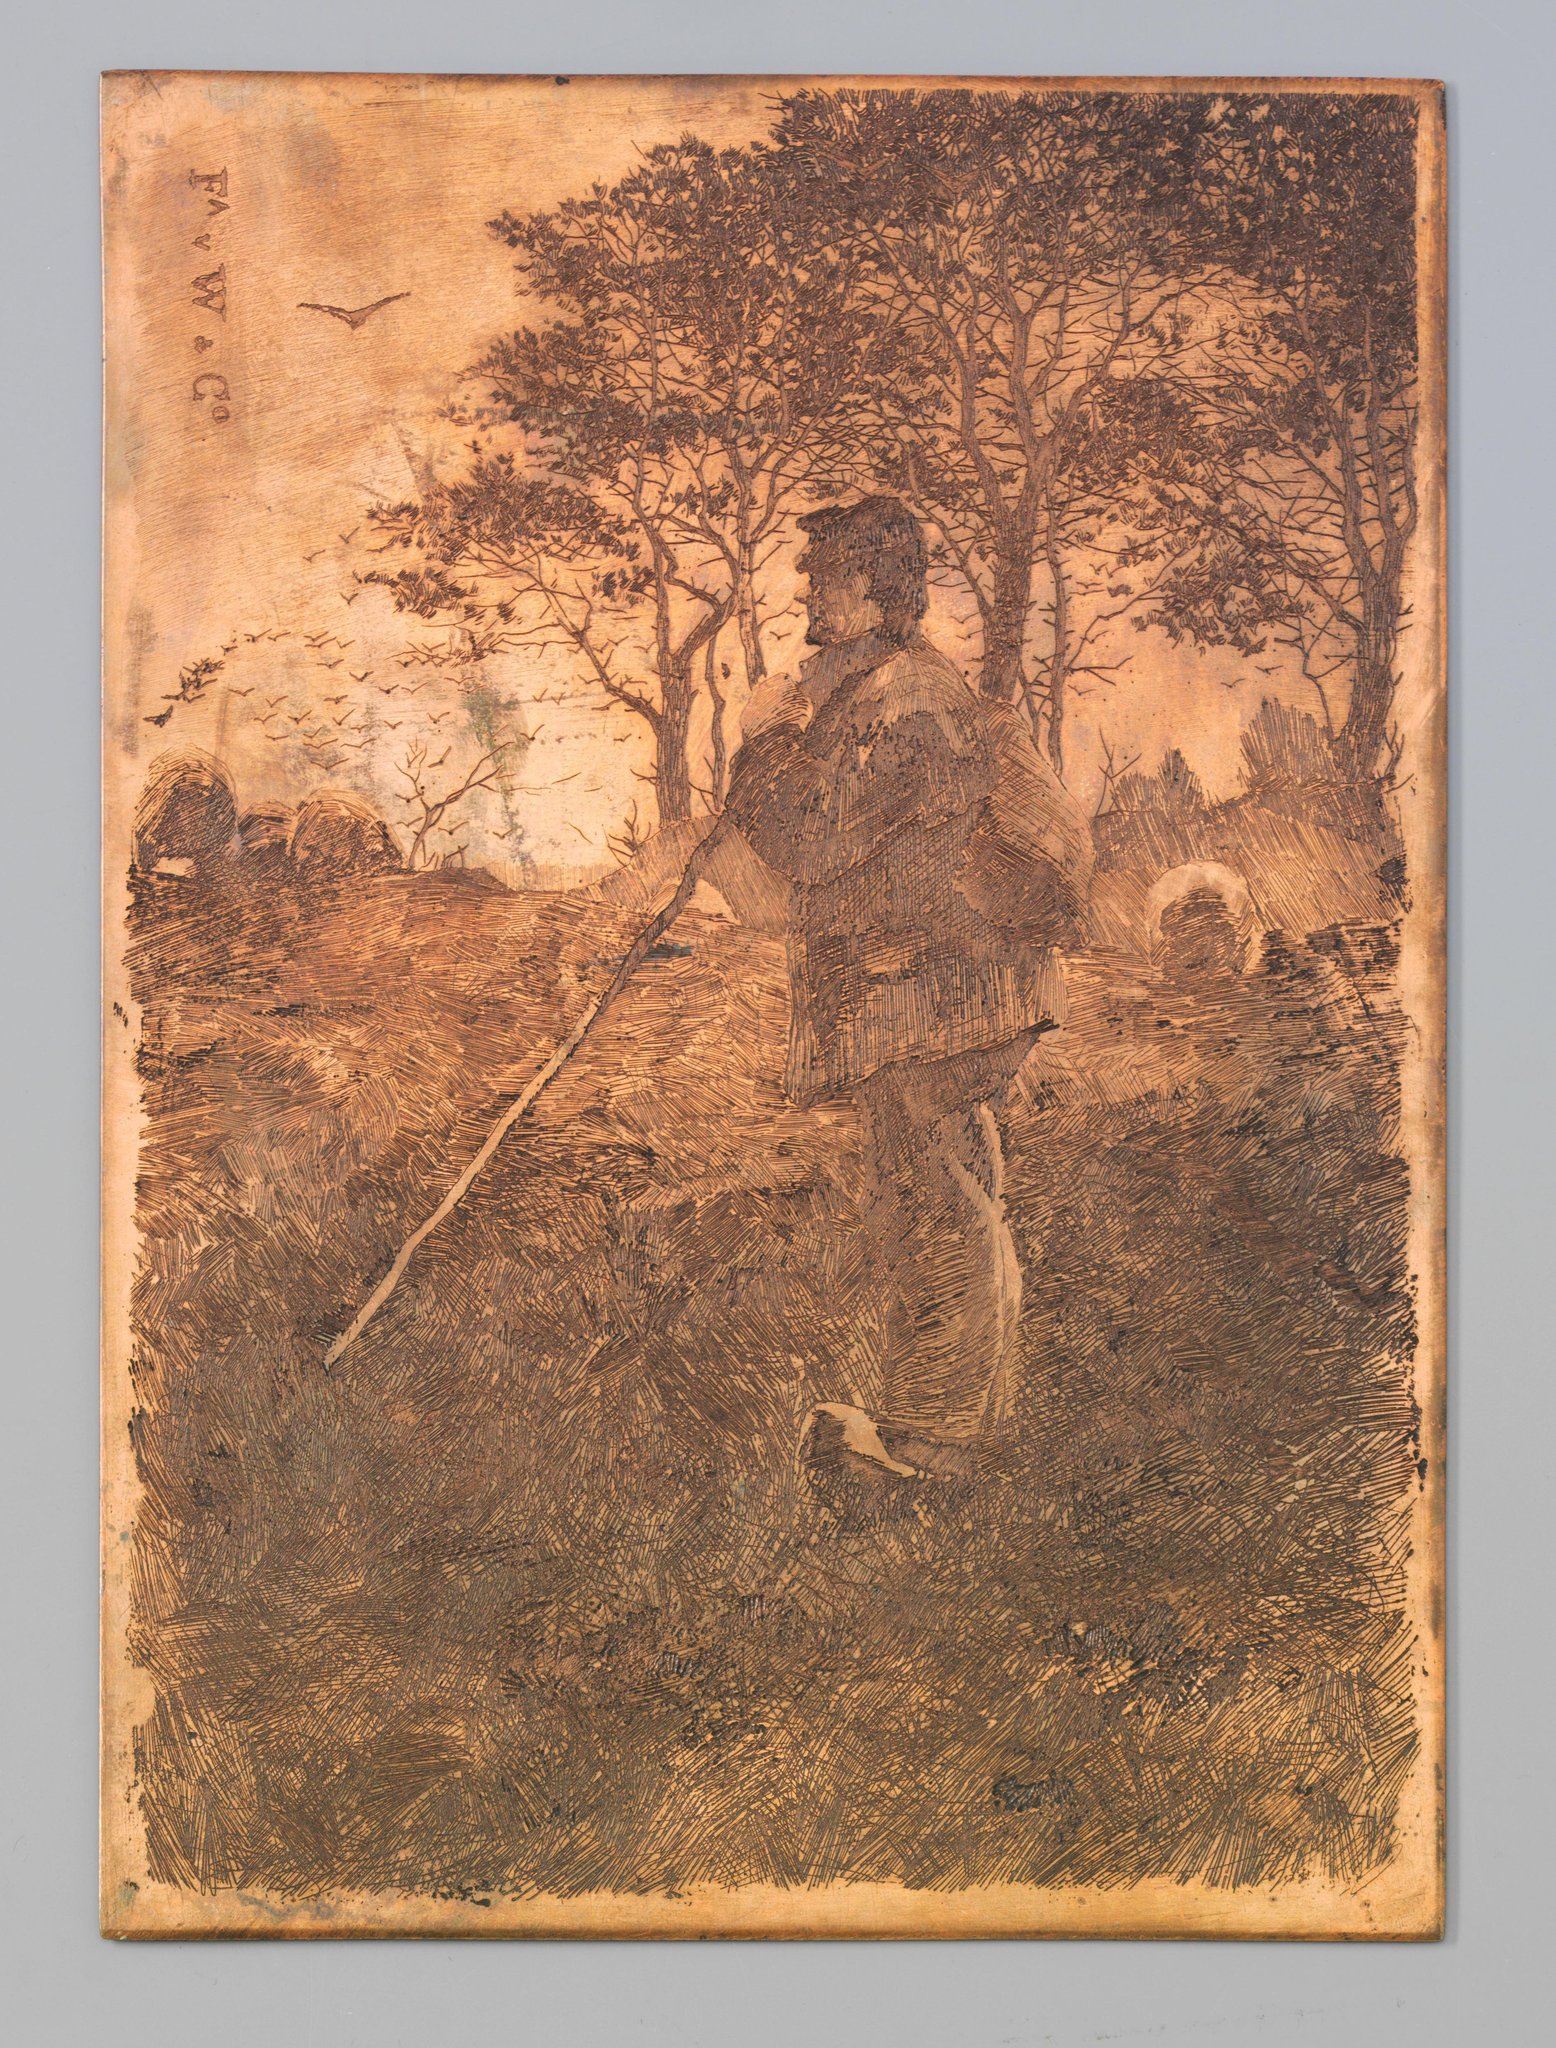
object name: copper plate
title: Schaapherder leunend op zijn staf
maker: willem witsen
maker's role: draughtsman, painter, print maker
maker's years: 1860-1923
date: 1886-1906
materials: copper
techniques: etching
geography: ewijkshoeve